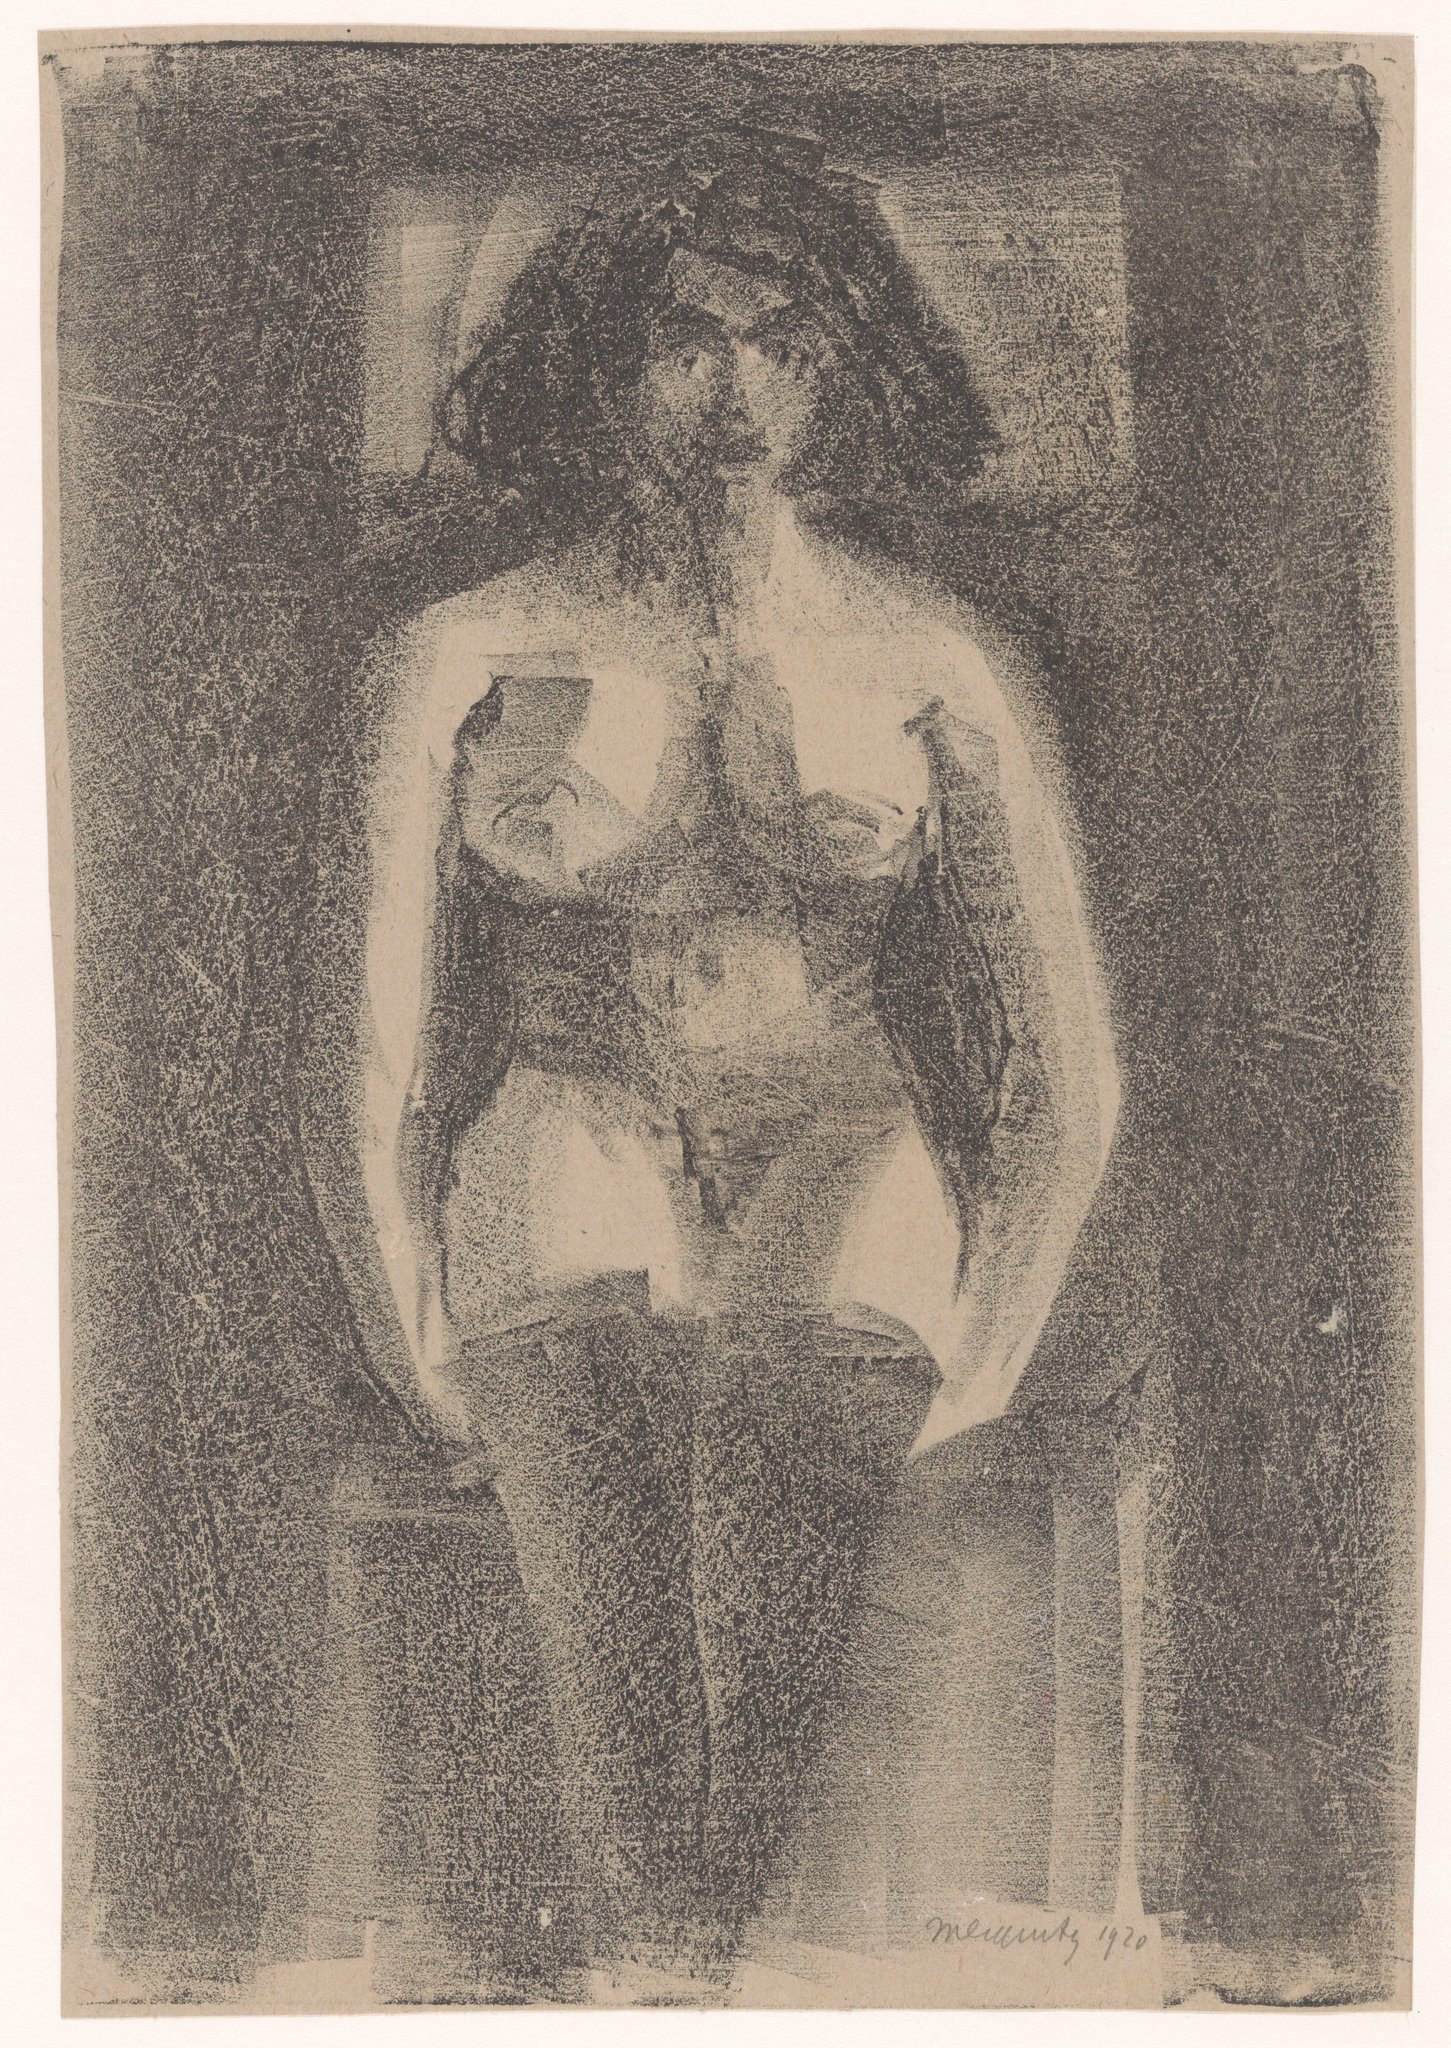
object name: print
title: Zittend vrouwelijk naakt, met kousen aan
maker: samuel jessurun de mesquita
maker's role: draughtsman, print maker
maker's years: 1868-1944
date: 1920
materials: paper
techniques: lithograph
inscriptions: signature and date: ‘mesquita 1920’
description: Zittend vrouwelijk naakt, met kousen aan.